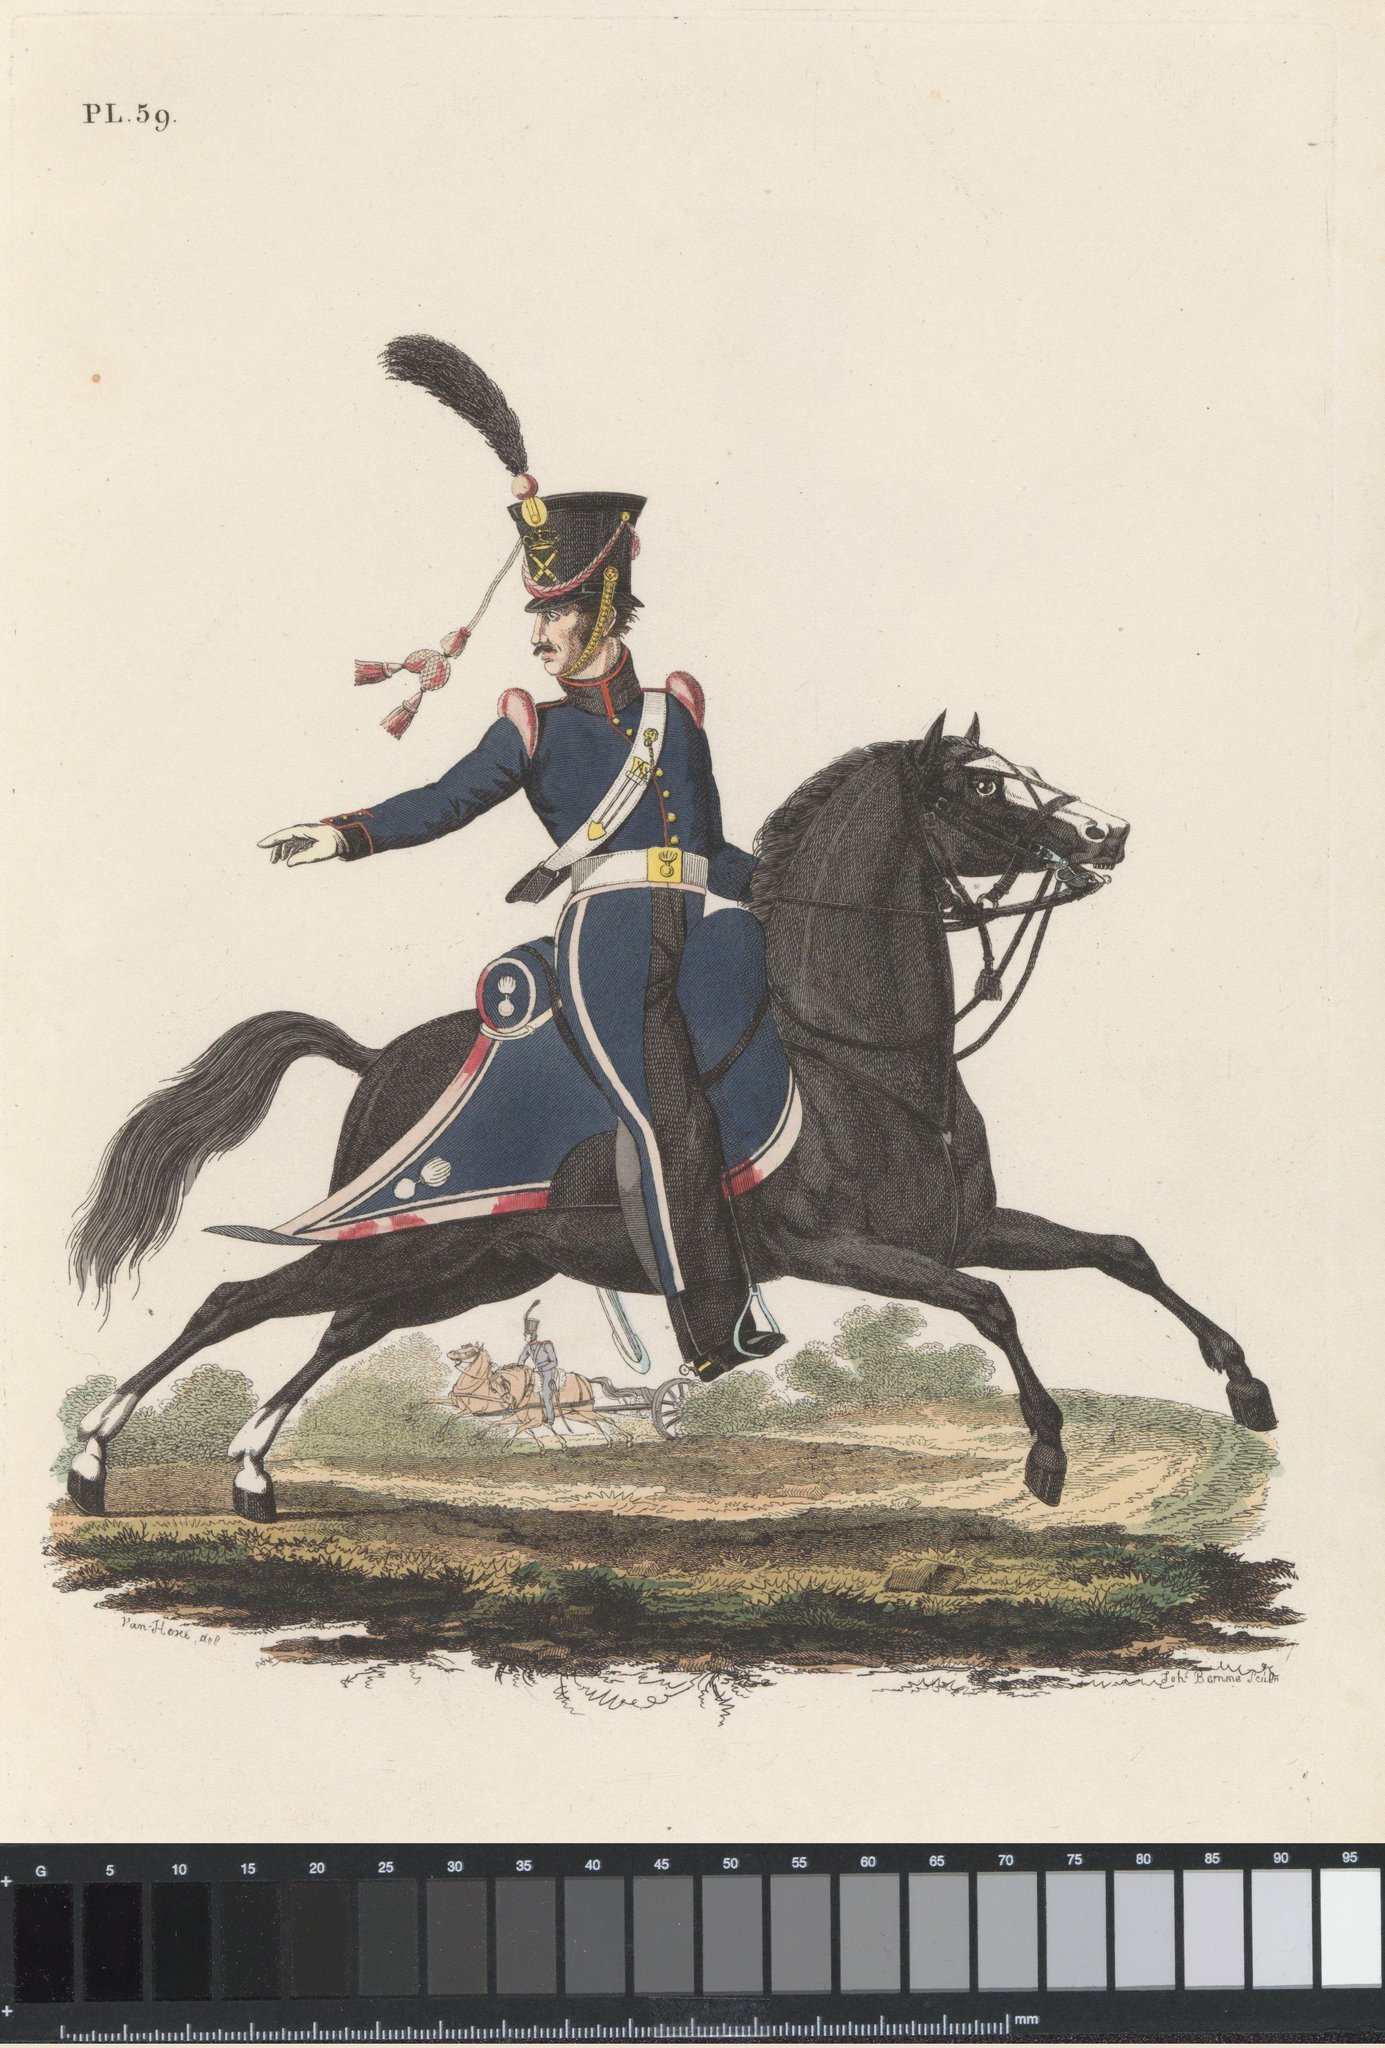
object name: print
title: Kanonnier, te paard, der Rijdende Artillerie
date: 1826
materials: paper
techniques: engraving, etching, hand coloring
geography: netherlands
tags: (military) uniforms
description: Een Nederlandse kanonnier van de rijdende artillerie te paard. Plaat 59. Uniformvoorstelling in 'Vervolg van de Beschrijving hoedanig de Koninklijke Nederlandsche troepen' van J.F. Teupken, 1826.